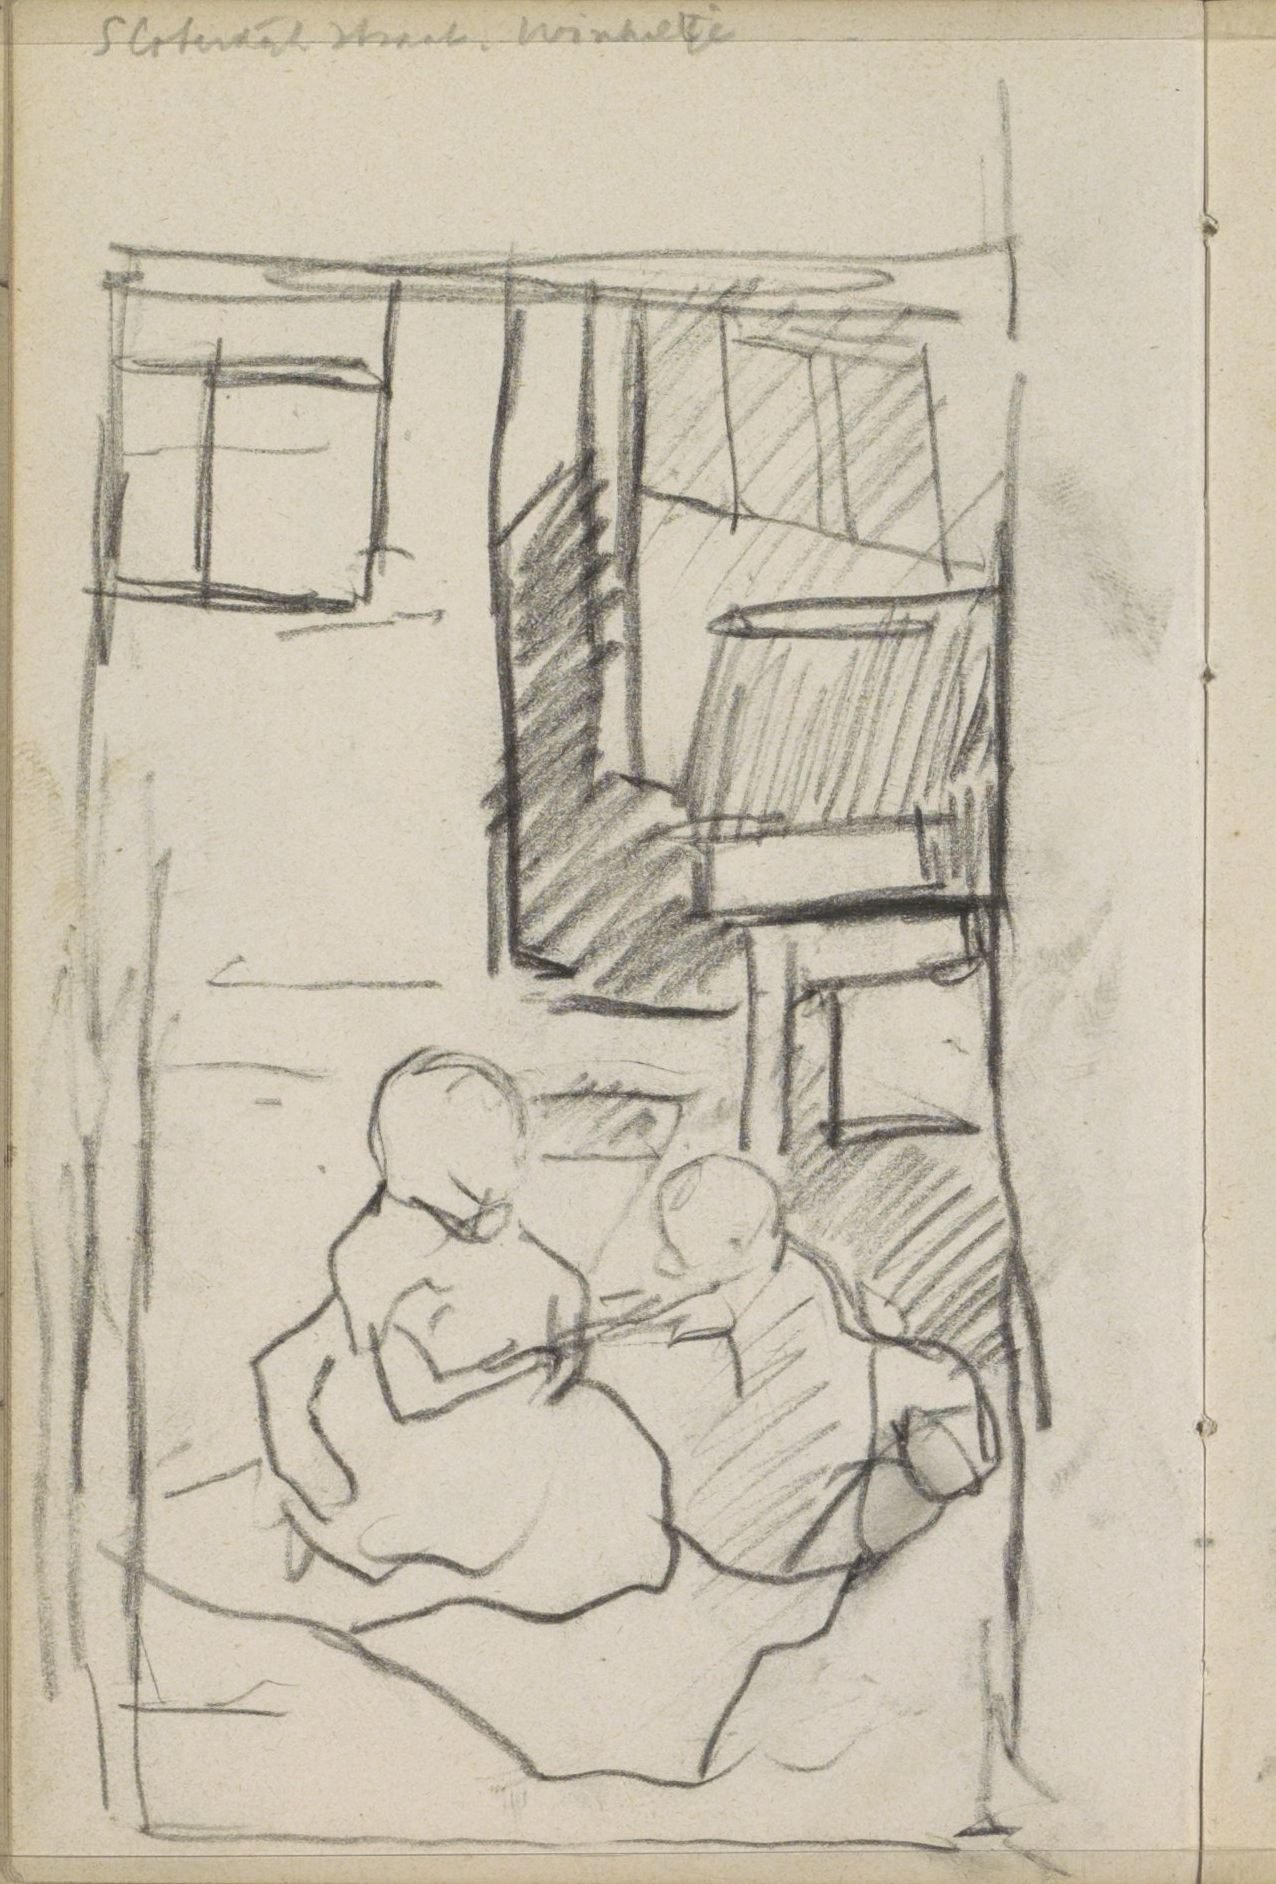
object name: sketchbook leaf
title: Twee kinderen in een winkel in de Sloterdijkstraat te Amsterdam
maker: george hendrik breitner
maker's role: draughtsman, painter, print maker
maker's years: 1857-1923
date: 1902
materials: chalk, paper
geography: amsterdam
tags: shop, store, child (+ two persons)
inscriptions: annotation: ‘Sloterdijkstraat. winkeltje’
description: Pagina 55 uit een schetsboek met 46 bladen vervaardigd in de omgeving van Amsterdam, Rotterdam en Haarlem.